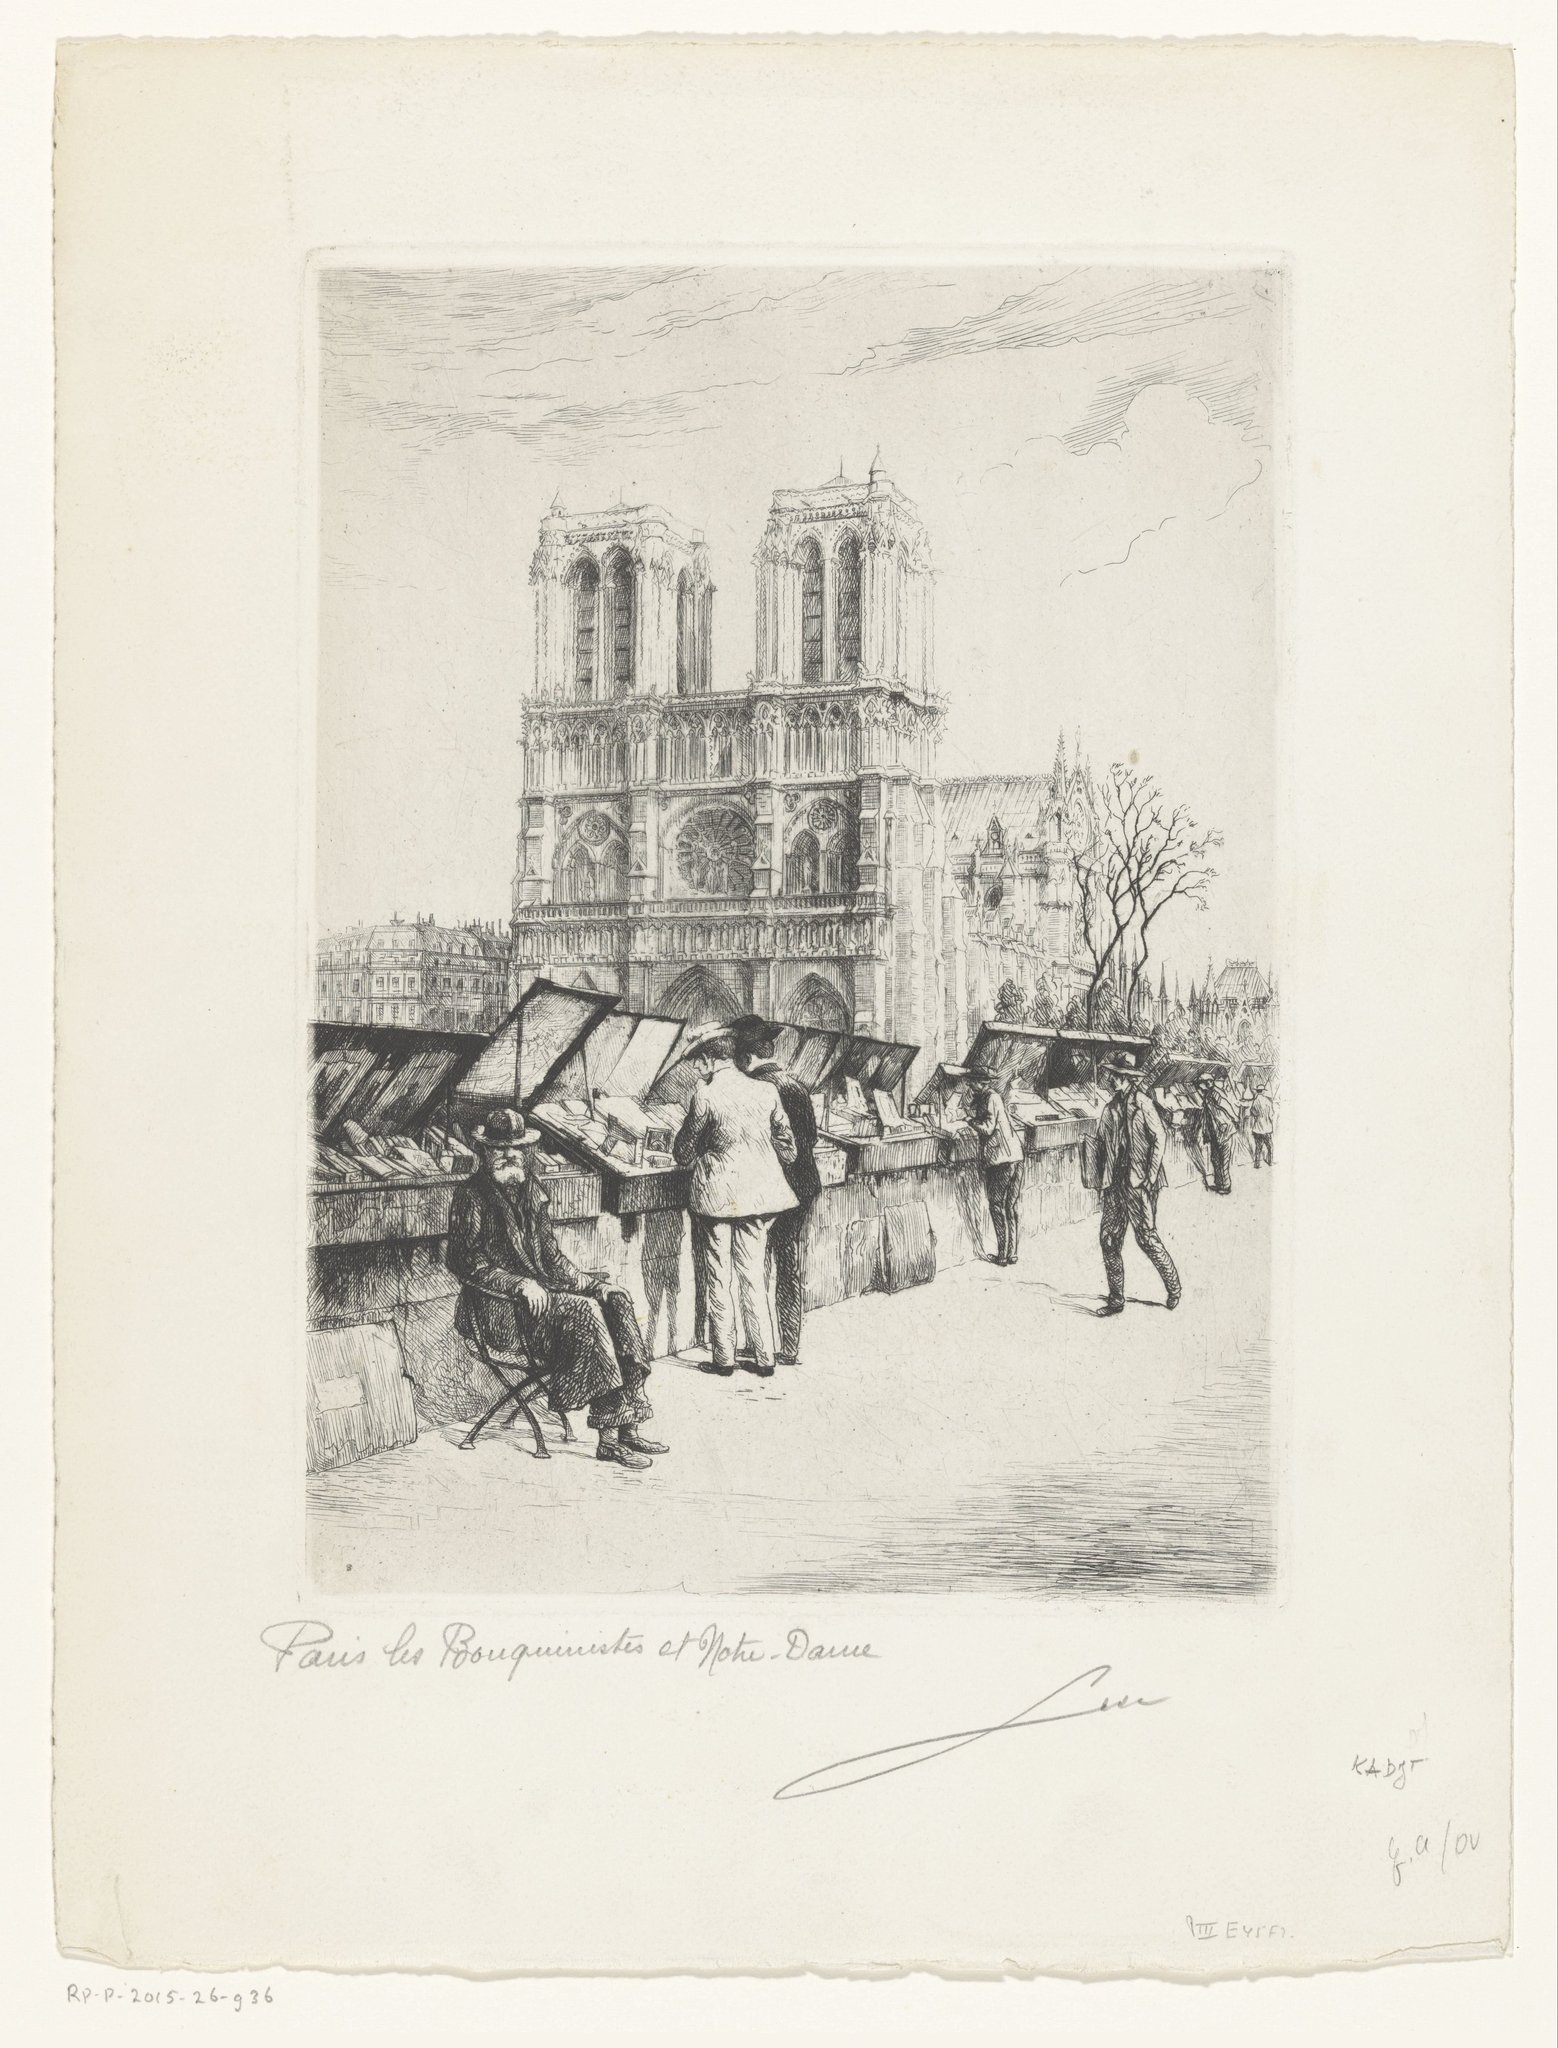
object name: print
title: Boekhandelaren op een kade, de Notre-Dame in de achtergrond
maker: Anonymous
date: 1900-1925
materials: paper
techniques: drypoint, etching, intaglio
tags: book-stall, kiosk, street-trader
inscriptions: collector's mark: Lugt 4779, collector's mark: Lugt 2228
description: Waarschijnlijk is de Quai de Montebello afgebeeld.